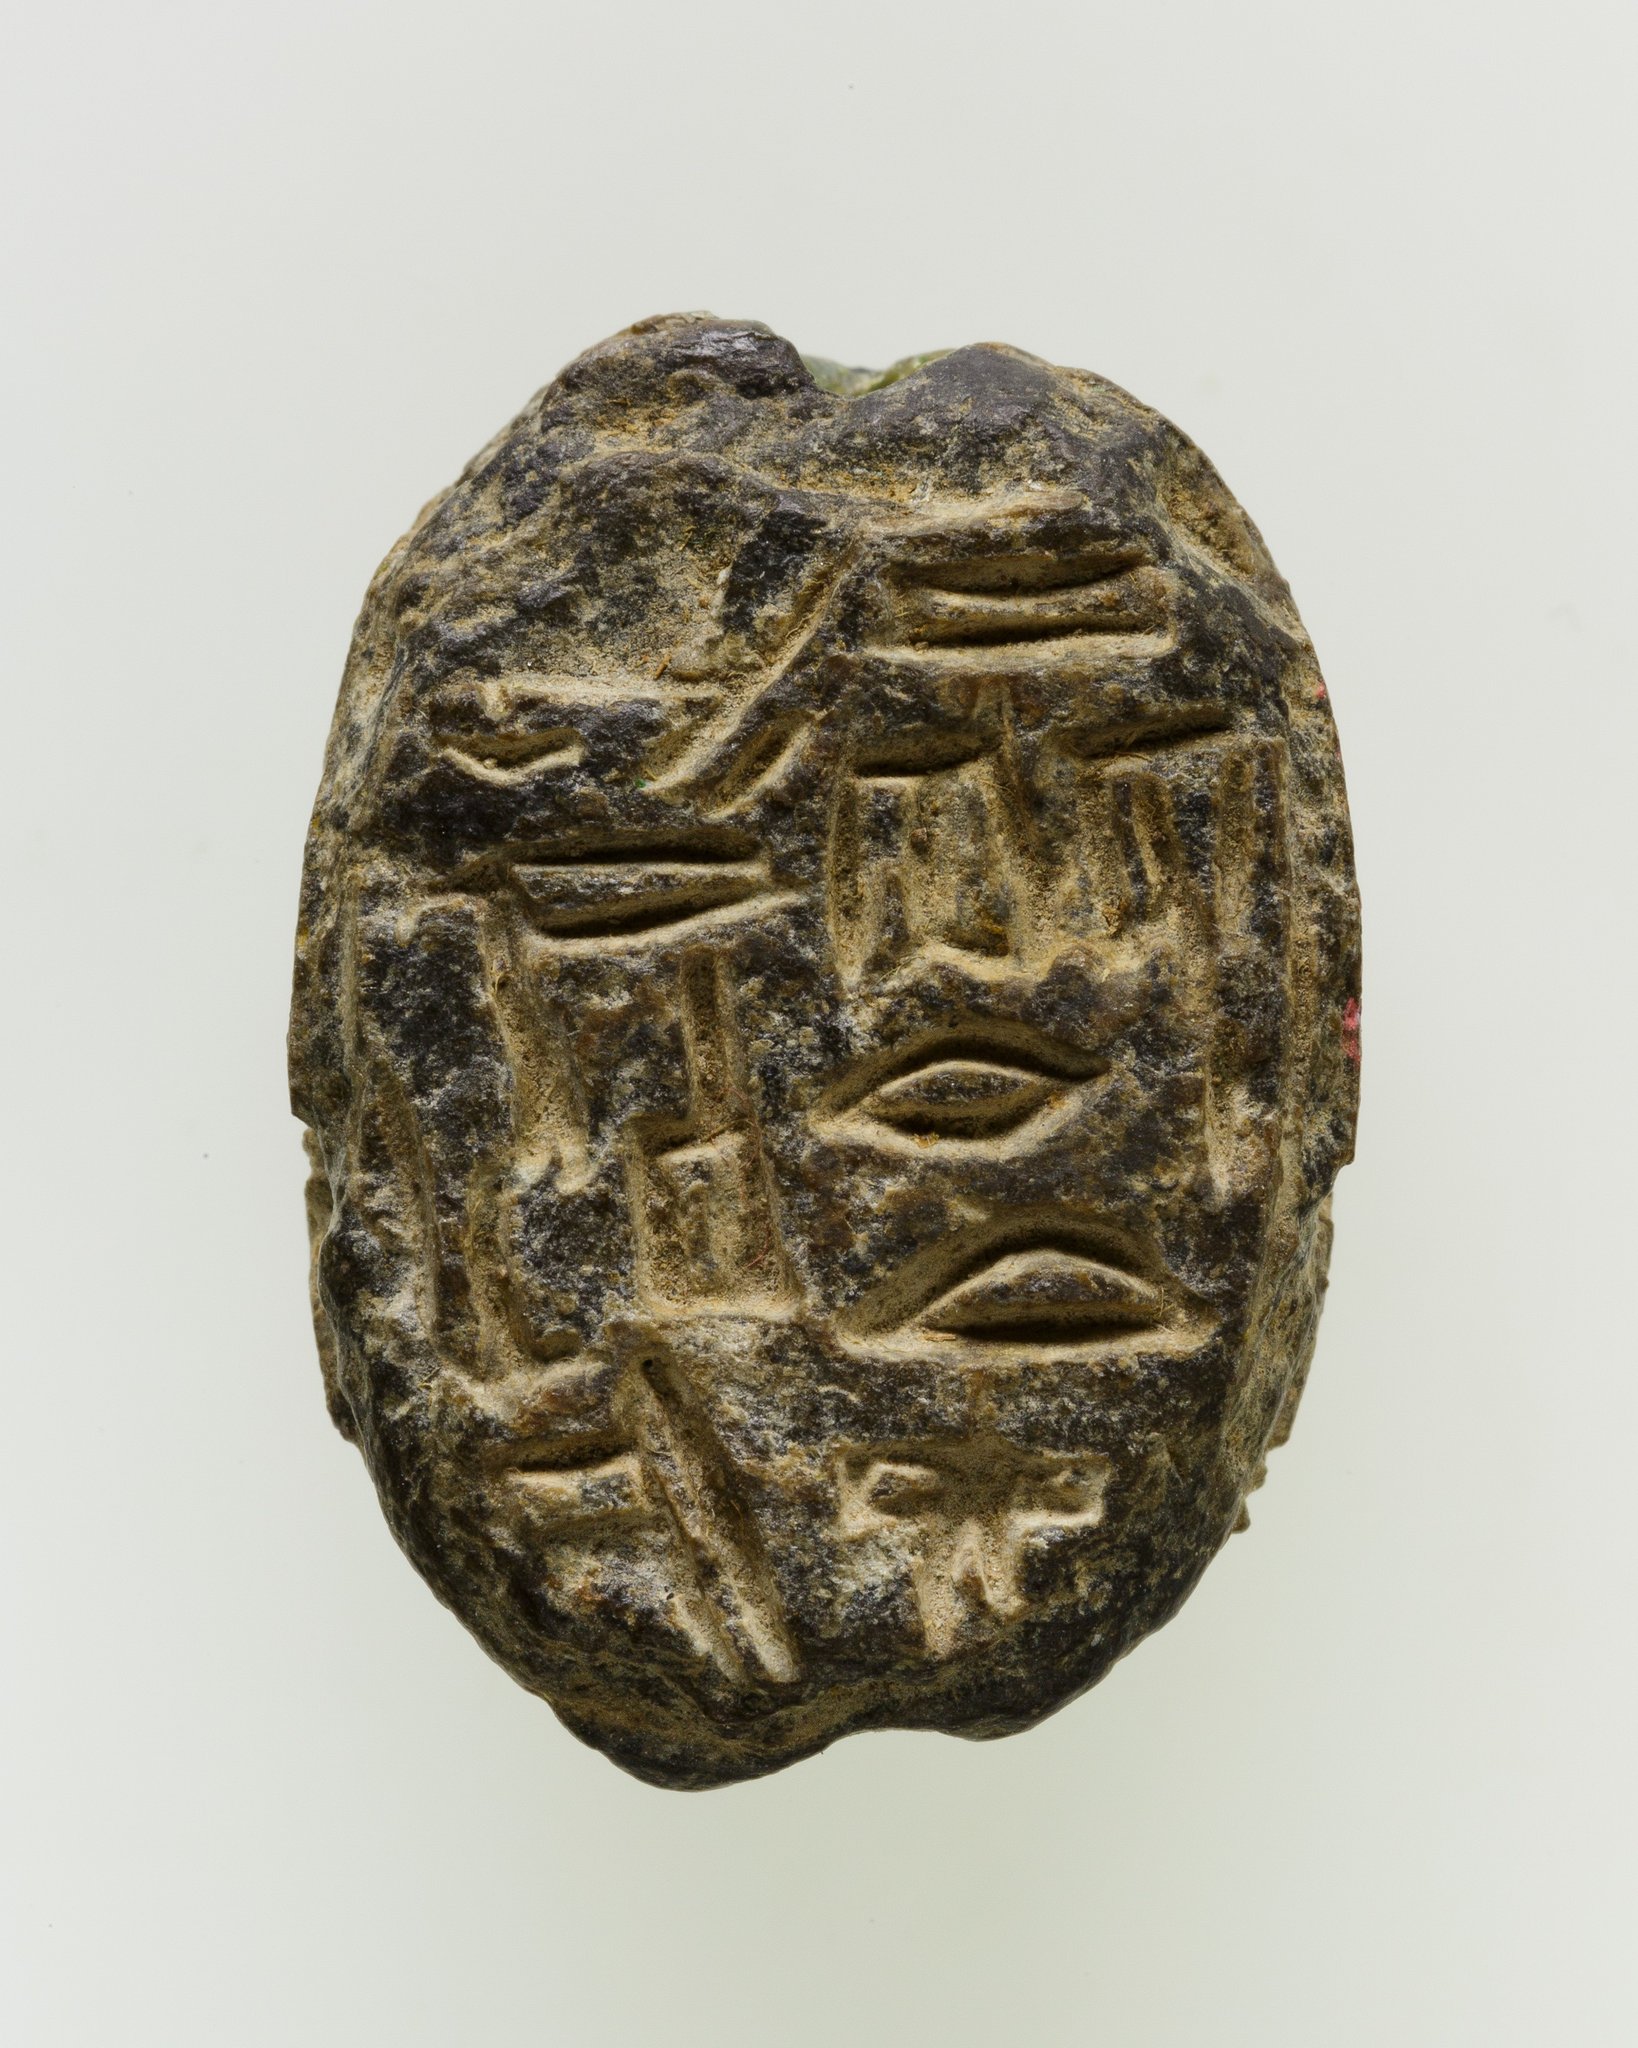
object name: scarab, official, private name and title, funerary epithet, nebersehwy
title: Scarab of an Official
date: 1740-1640 BCE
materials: stone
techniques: glazing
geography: egypt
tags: hieroglyphs,scarabs